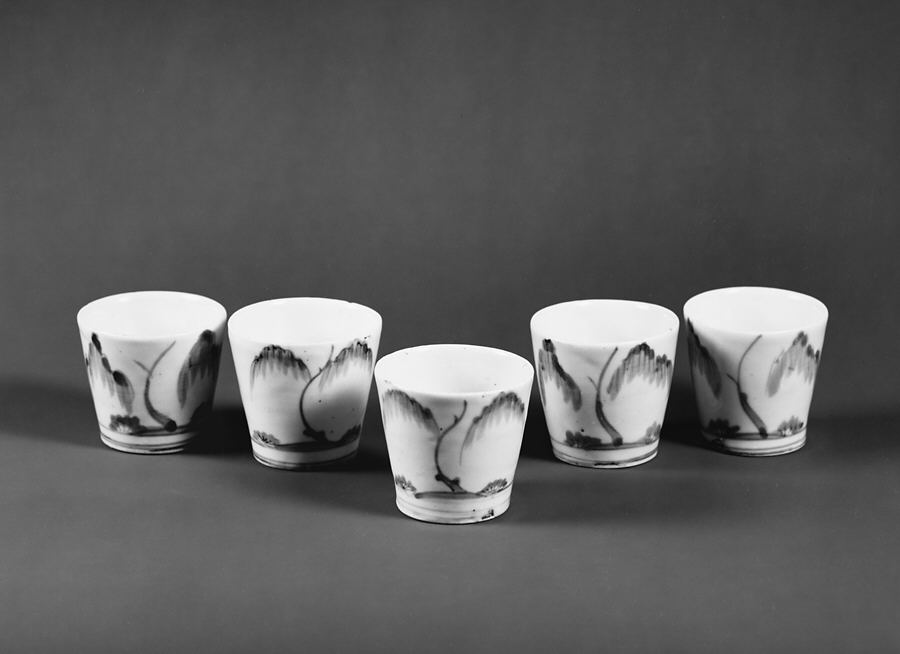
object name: soba cup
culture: japanese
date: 1667-1733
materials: porcelain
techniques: underglaze